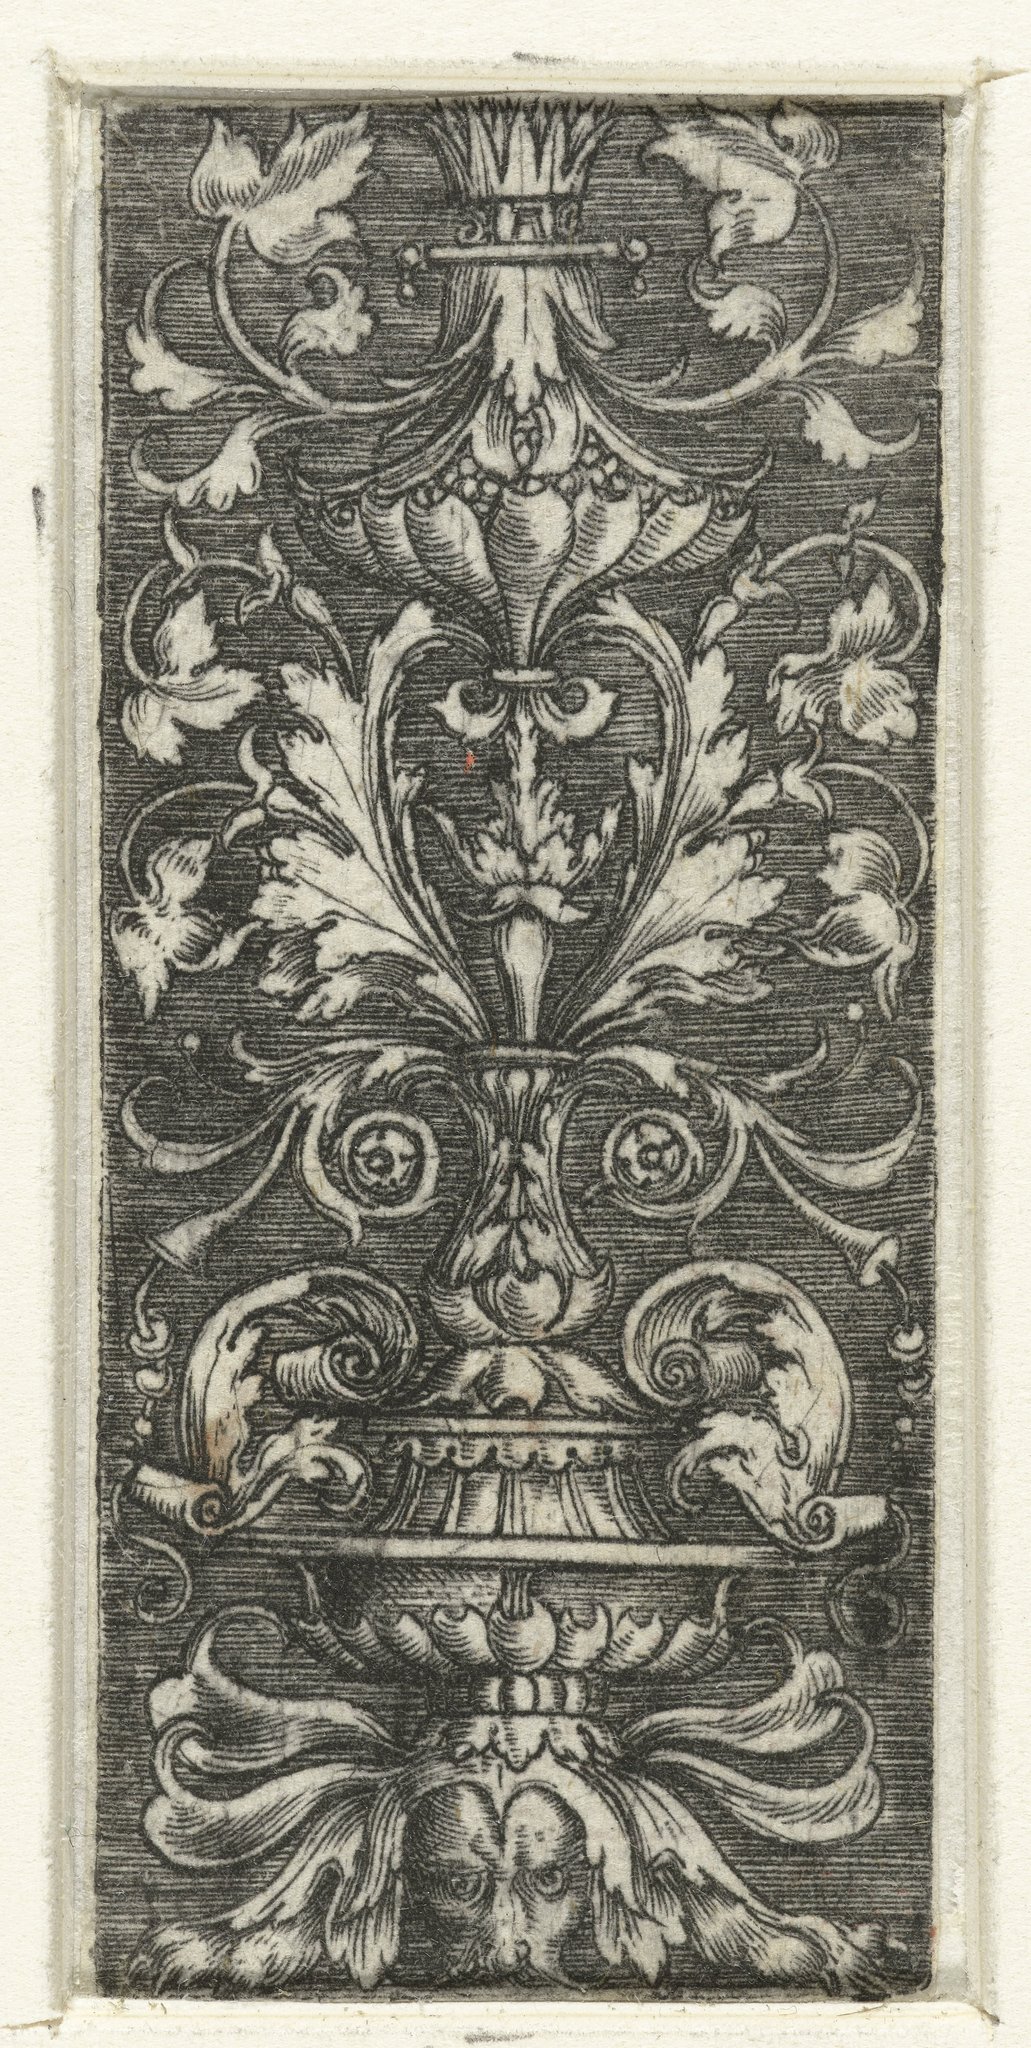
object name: print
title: Kandelaber met bladranken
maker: albrecht altdorfer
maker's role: draughtsman, print maker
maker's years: 1480-1538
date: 1506-1538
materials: paper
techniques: engraving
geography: germany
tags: ornament ~ candelabrum, mask, mascaron ~ ornament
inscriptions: collector's mark: Lugt 240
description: Vlakdecoratie met een kandelaber waaruit bladranken komen, en een masker als voetstuk.